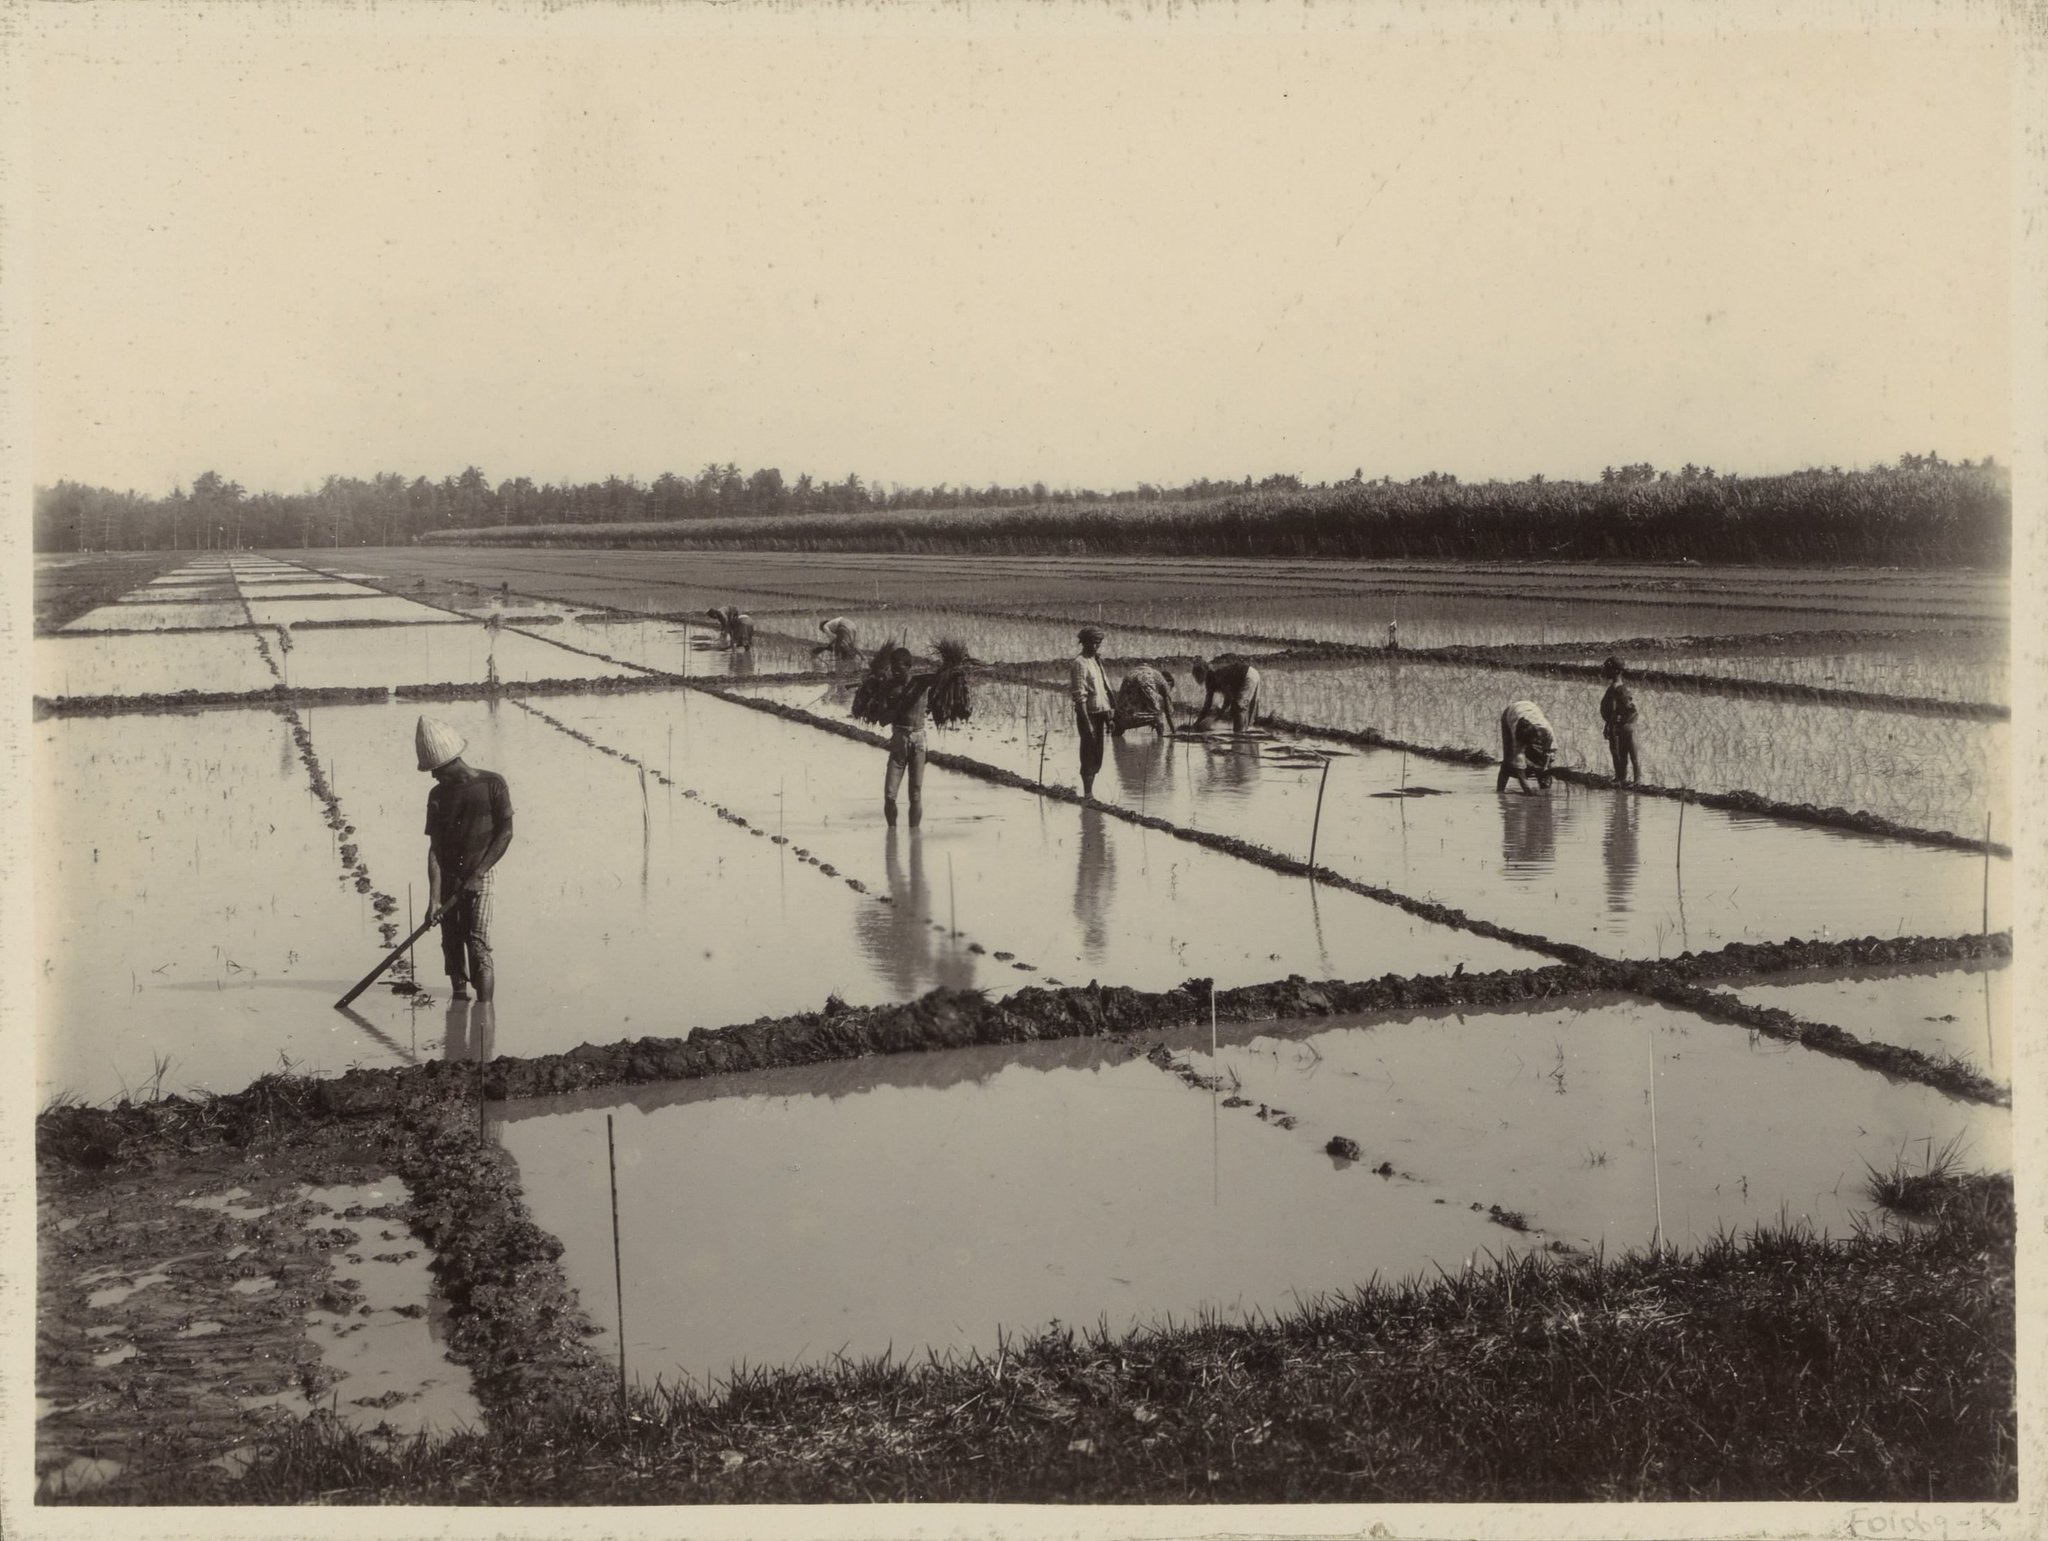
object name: photograph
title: Landarbeiders werkend op rijstvelden in Nederlands-Indië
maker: onnes kurkdjian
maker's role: fotograaf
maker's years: 1851-1903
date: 1912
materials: paper, photographic support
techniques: gelatin silver print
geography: dutch east indies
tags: field filled with a crop, dutch east indies, the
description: Onderdeel van Reisalbum met veertig foto's van Nederlands-Indië.